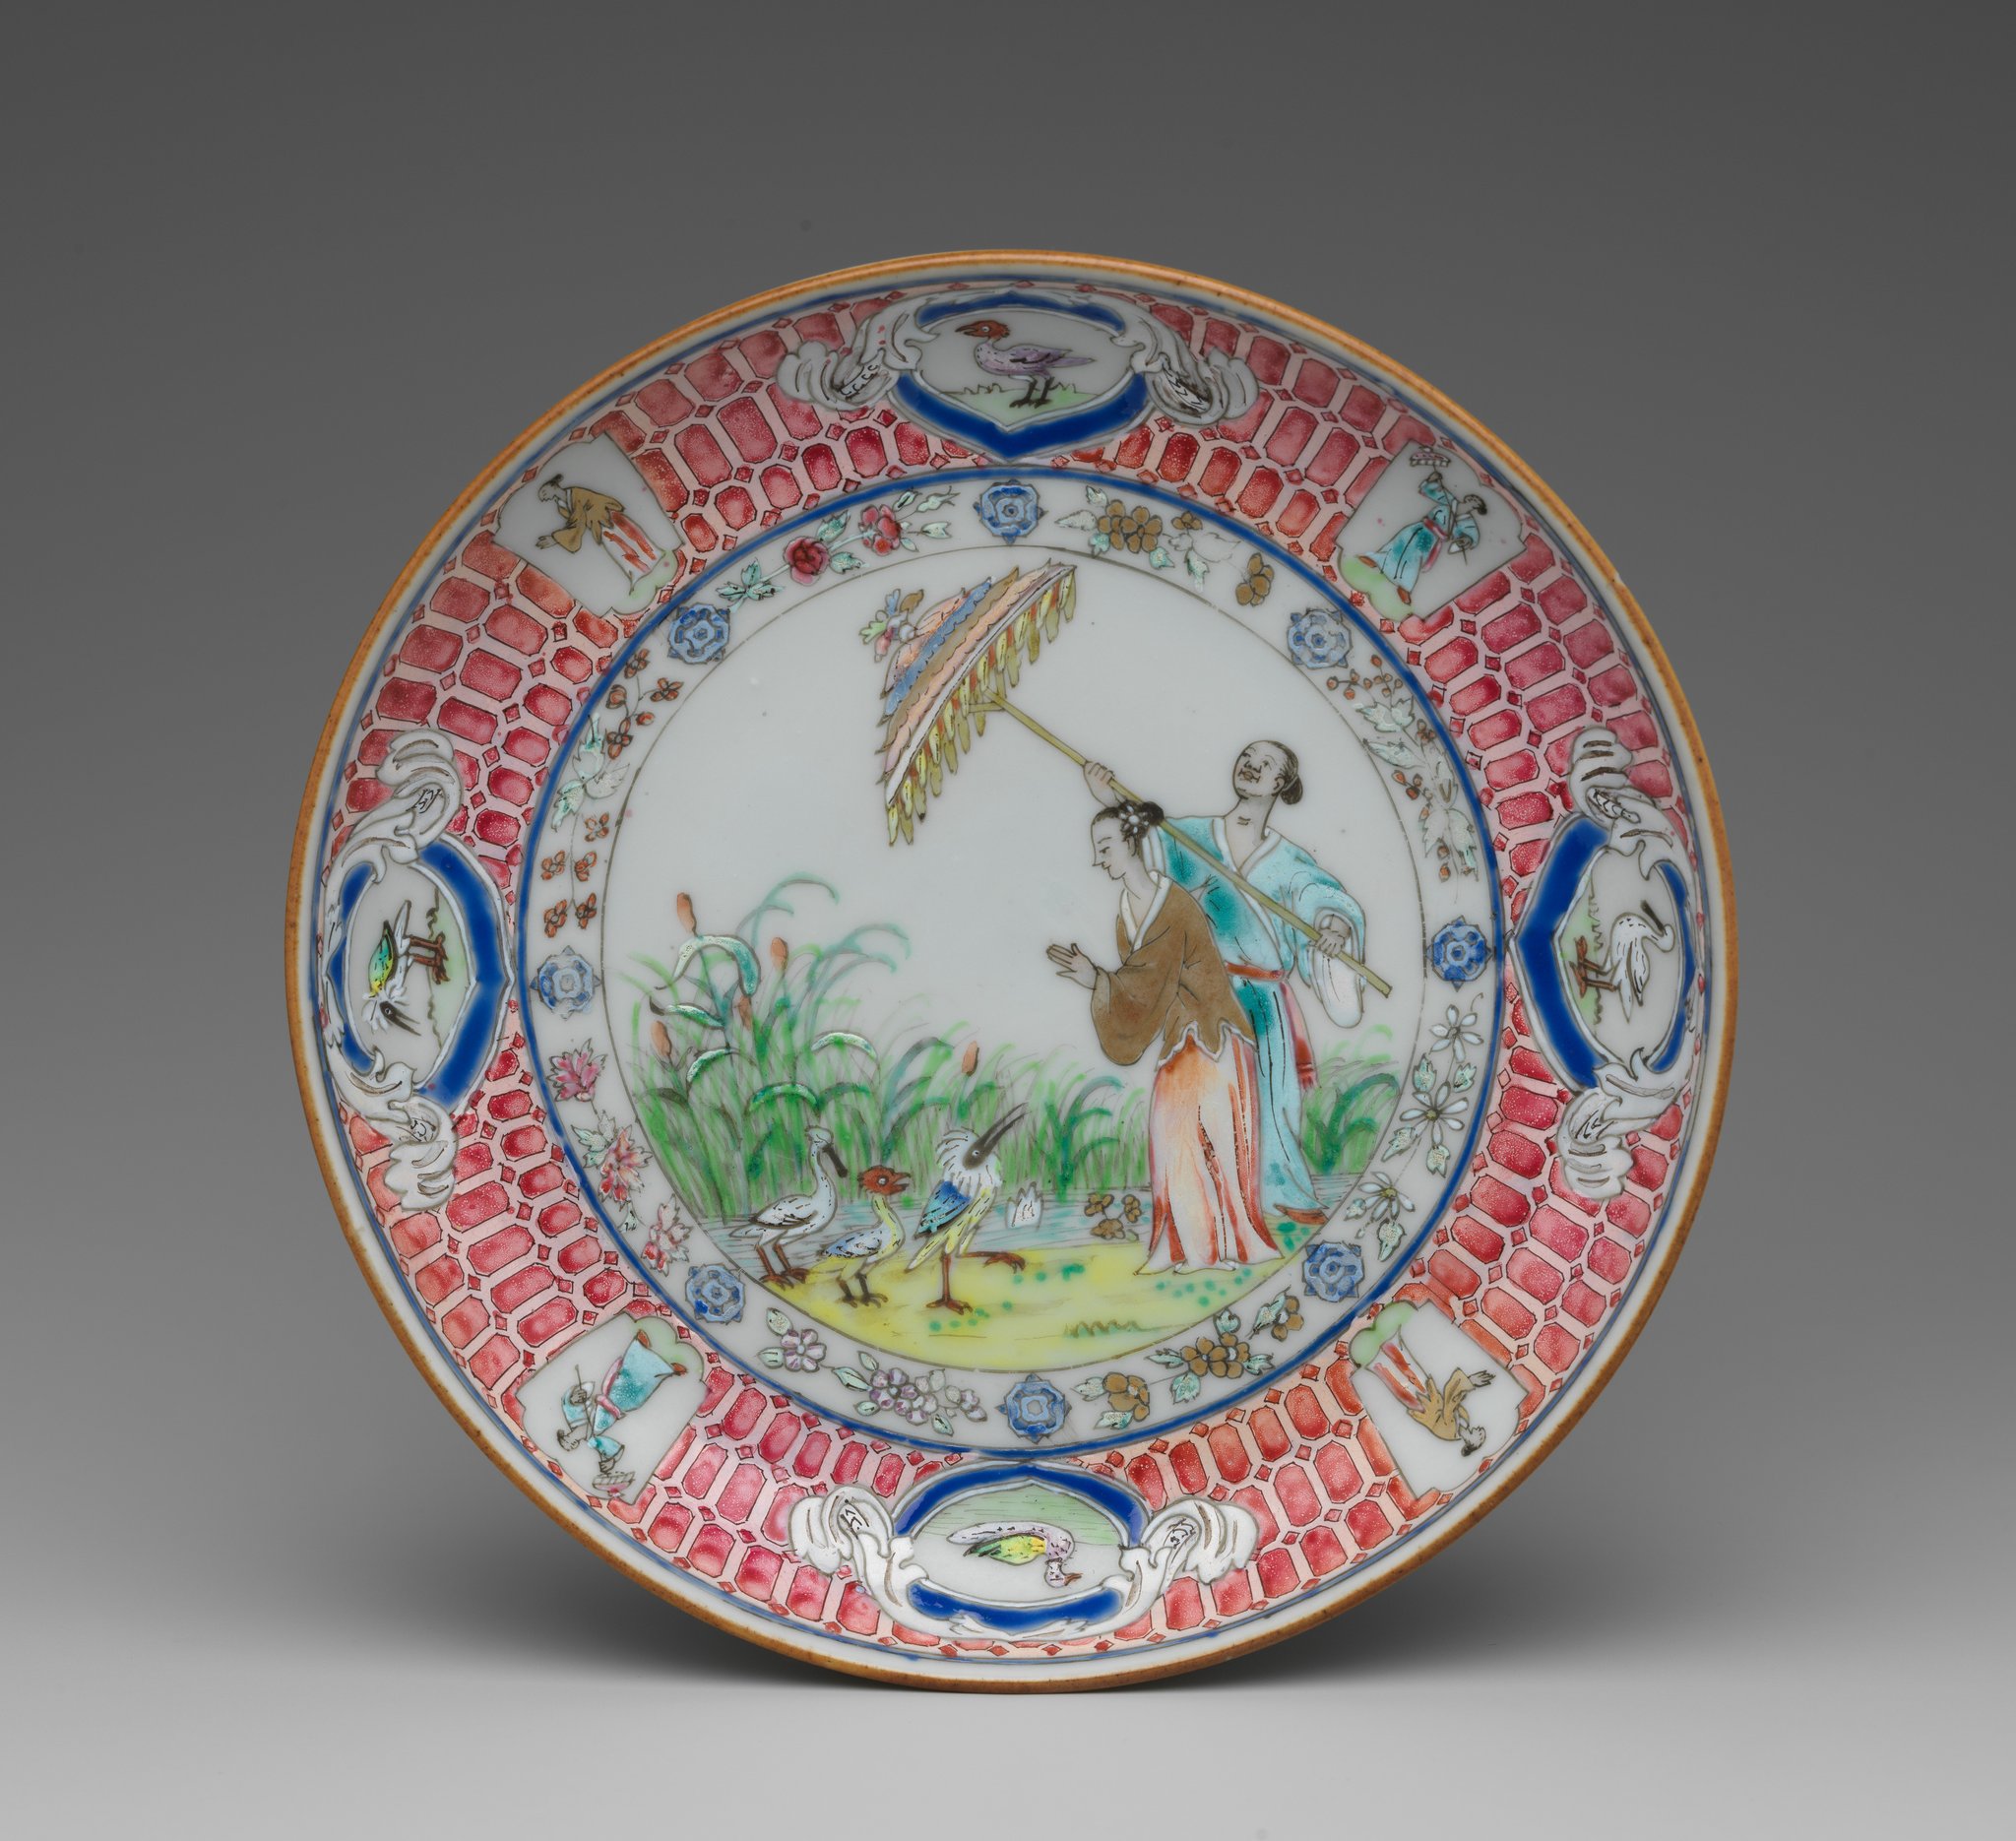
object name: dish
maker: cornelis pronk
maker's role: artist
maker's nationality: dutch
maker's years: 1691-1759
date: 1736-1738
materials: hard paste porcelain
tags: birds,men,women